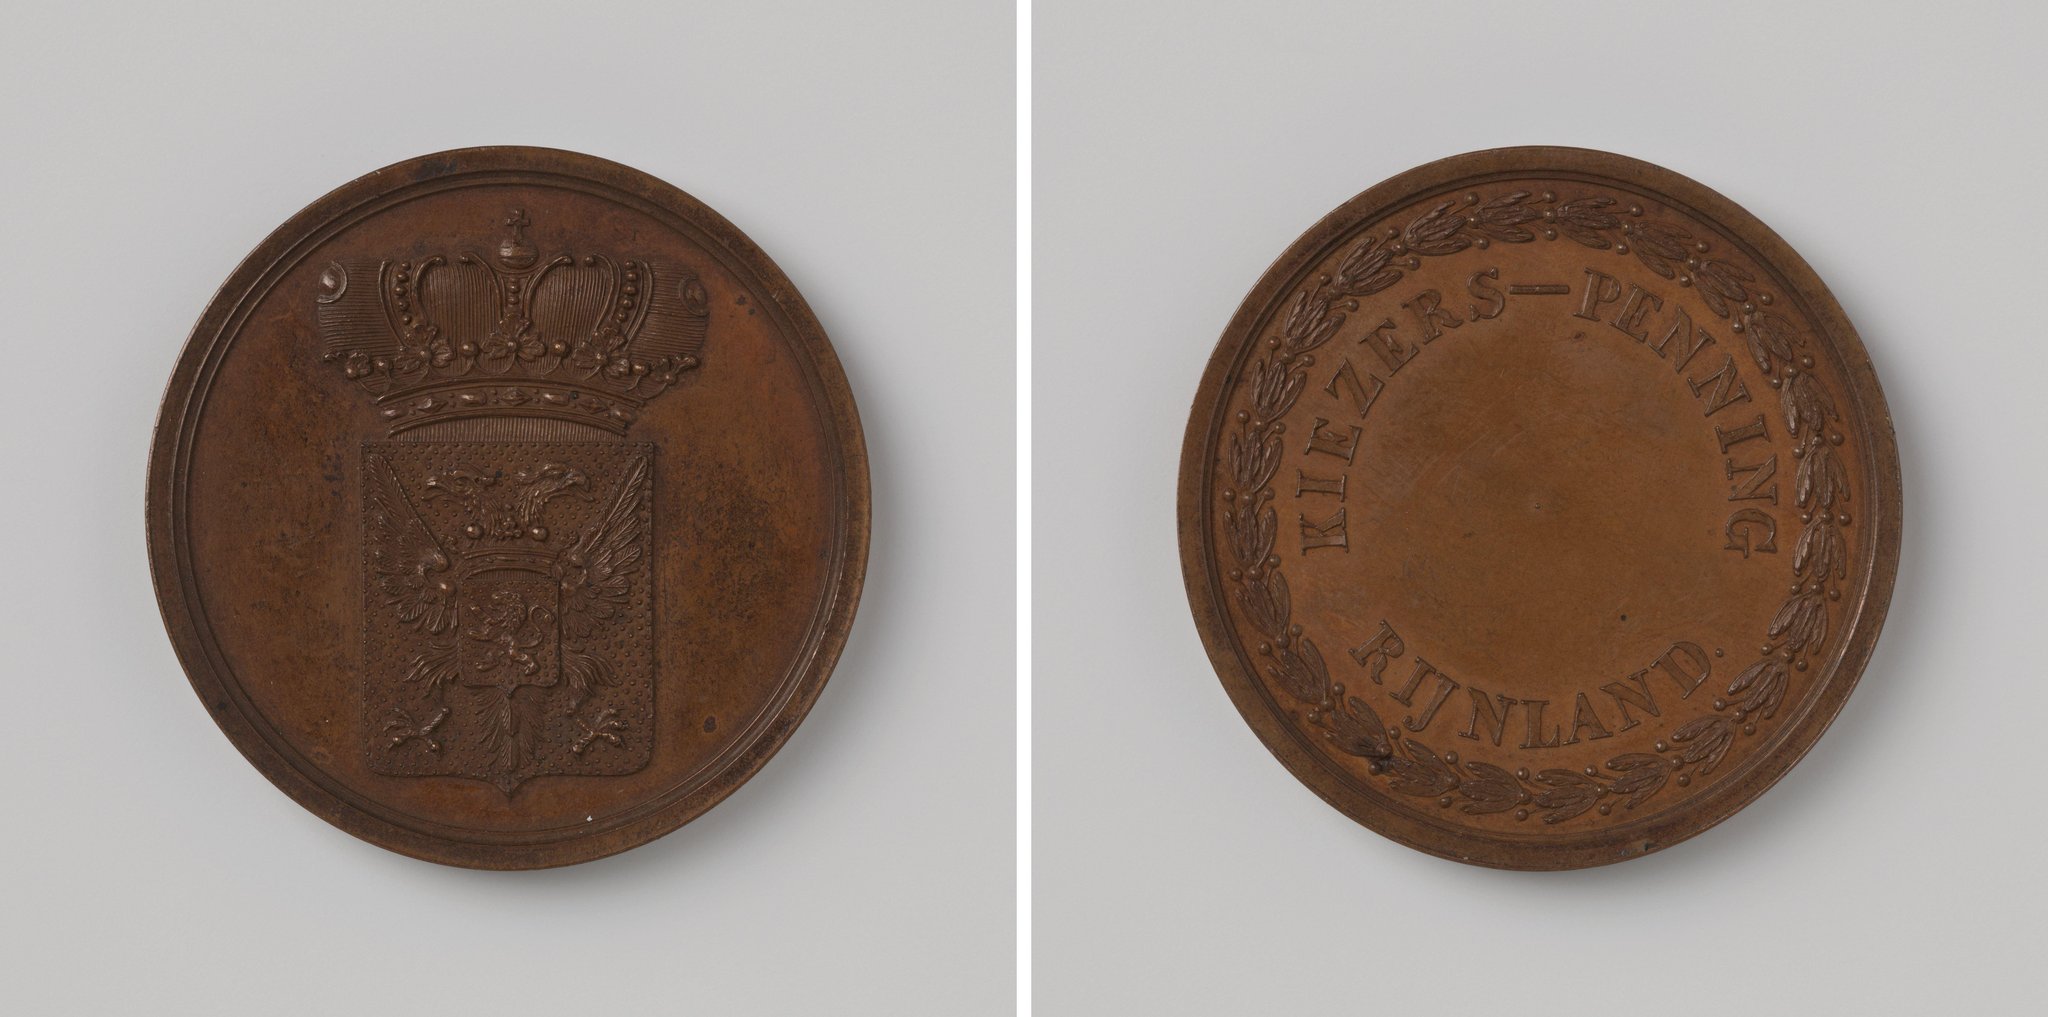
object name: lidmaatschapspenning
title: Verkiezing van de hoofd-ingelanden van het hoogheemraadschap Rijnland, penning uitgedeeld aan elke verschenen kiezer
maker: Anonymous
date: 1818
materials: bronze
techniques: striking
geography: netherlands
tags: netherlands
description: Bronzen penning. Voorzijde: gekroond wapenschild. Keerzijde: leeg veld binnen omschrift en lauwerkrans